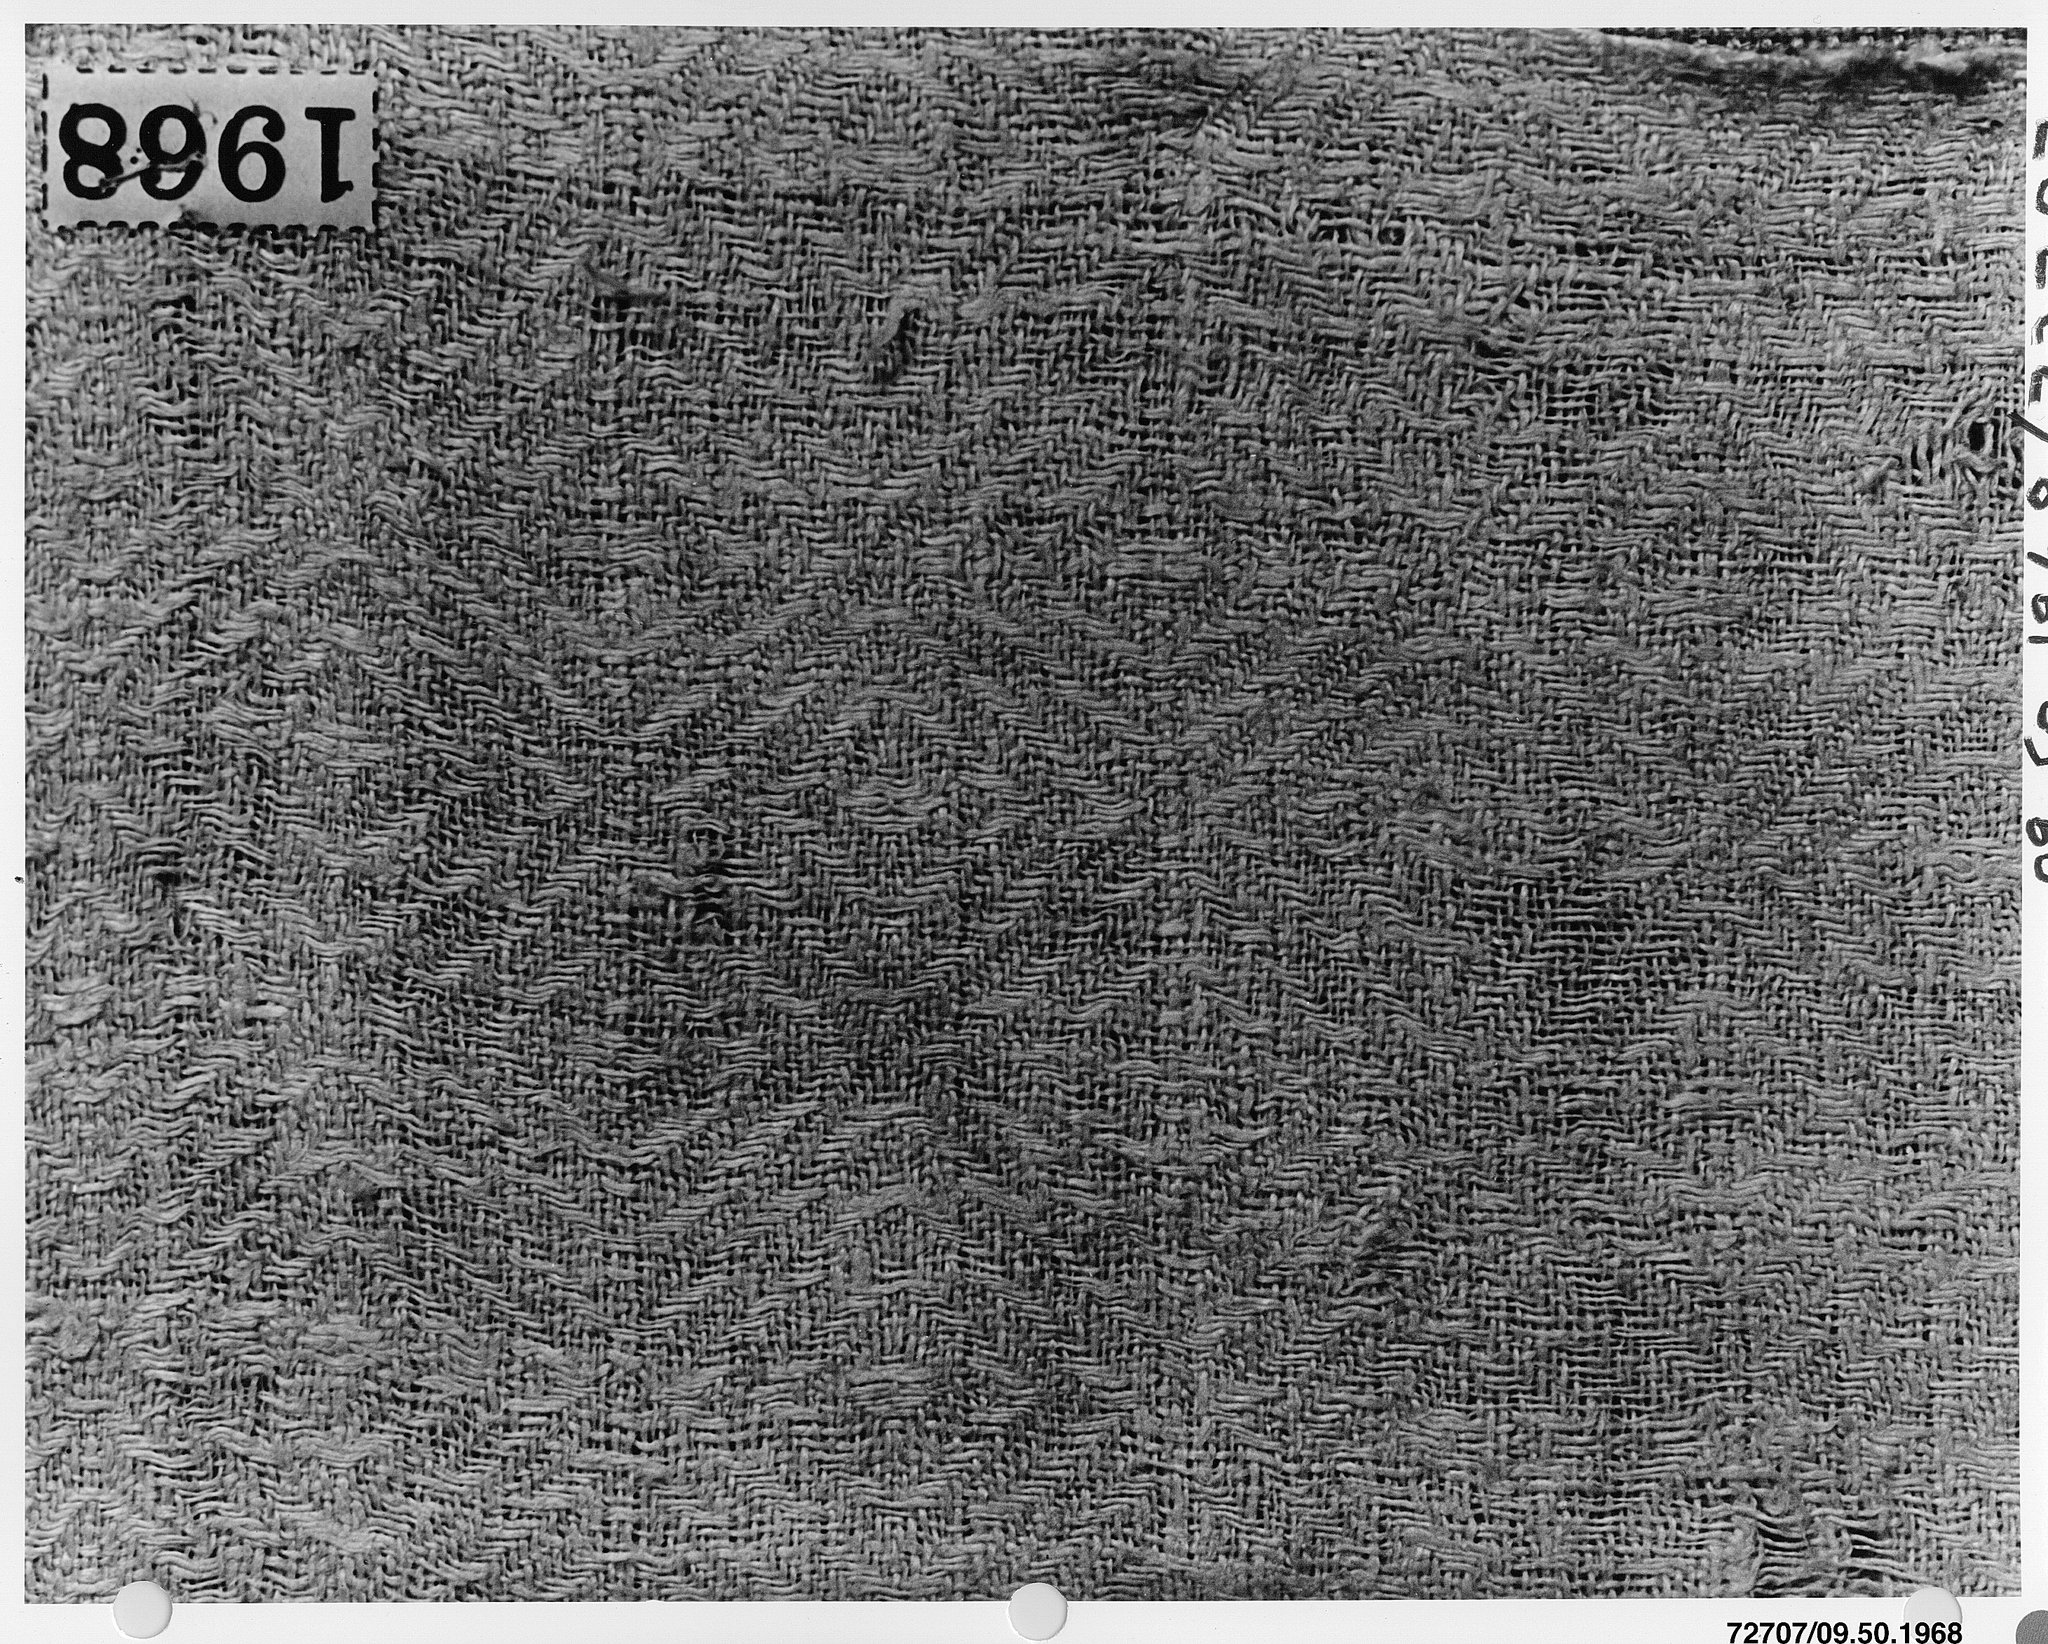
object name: fragment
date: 1701-1900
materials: linen